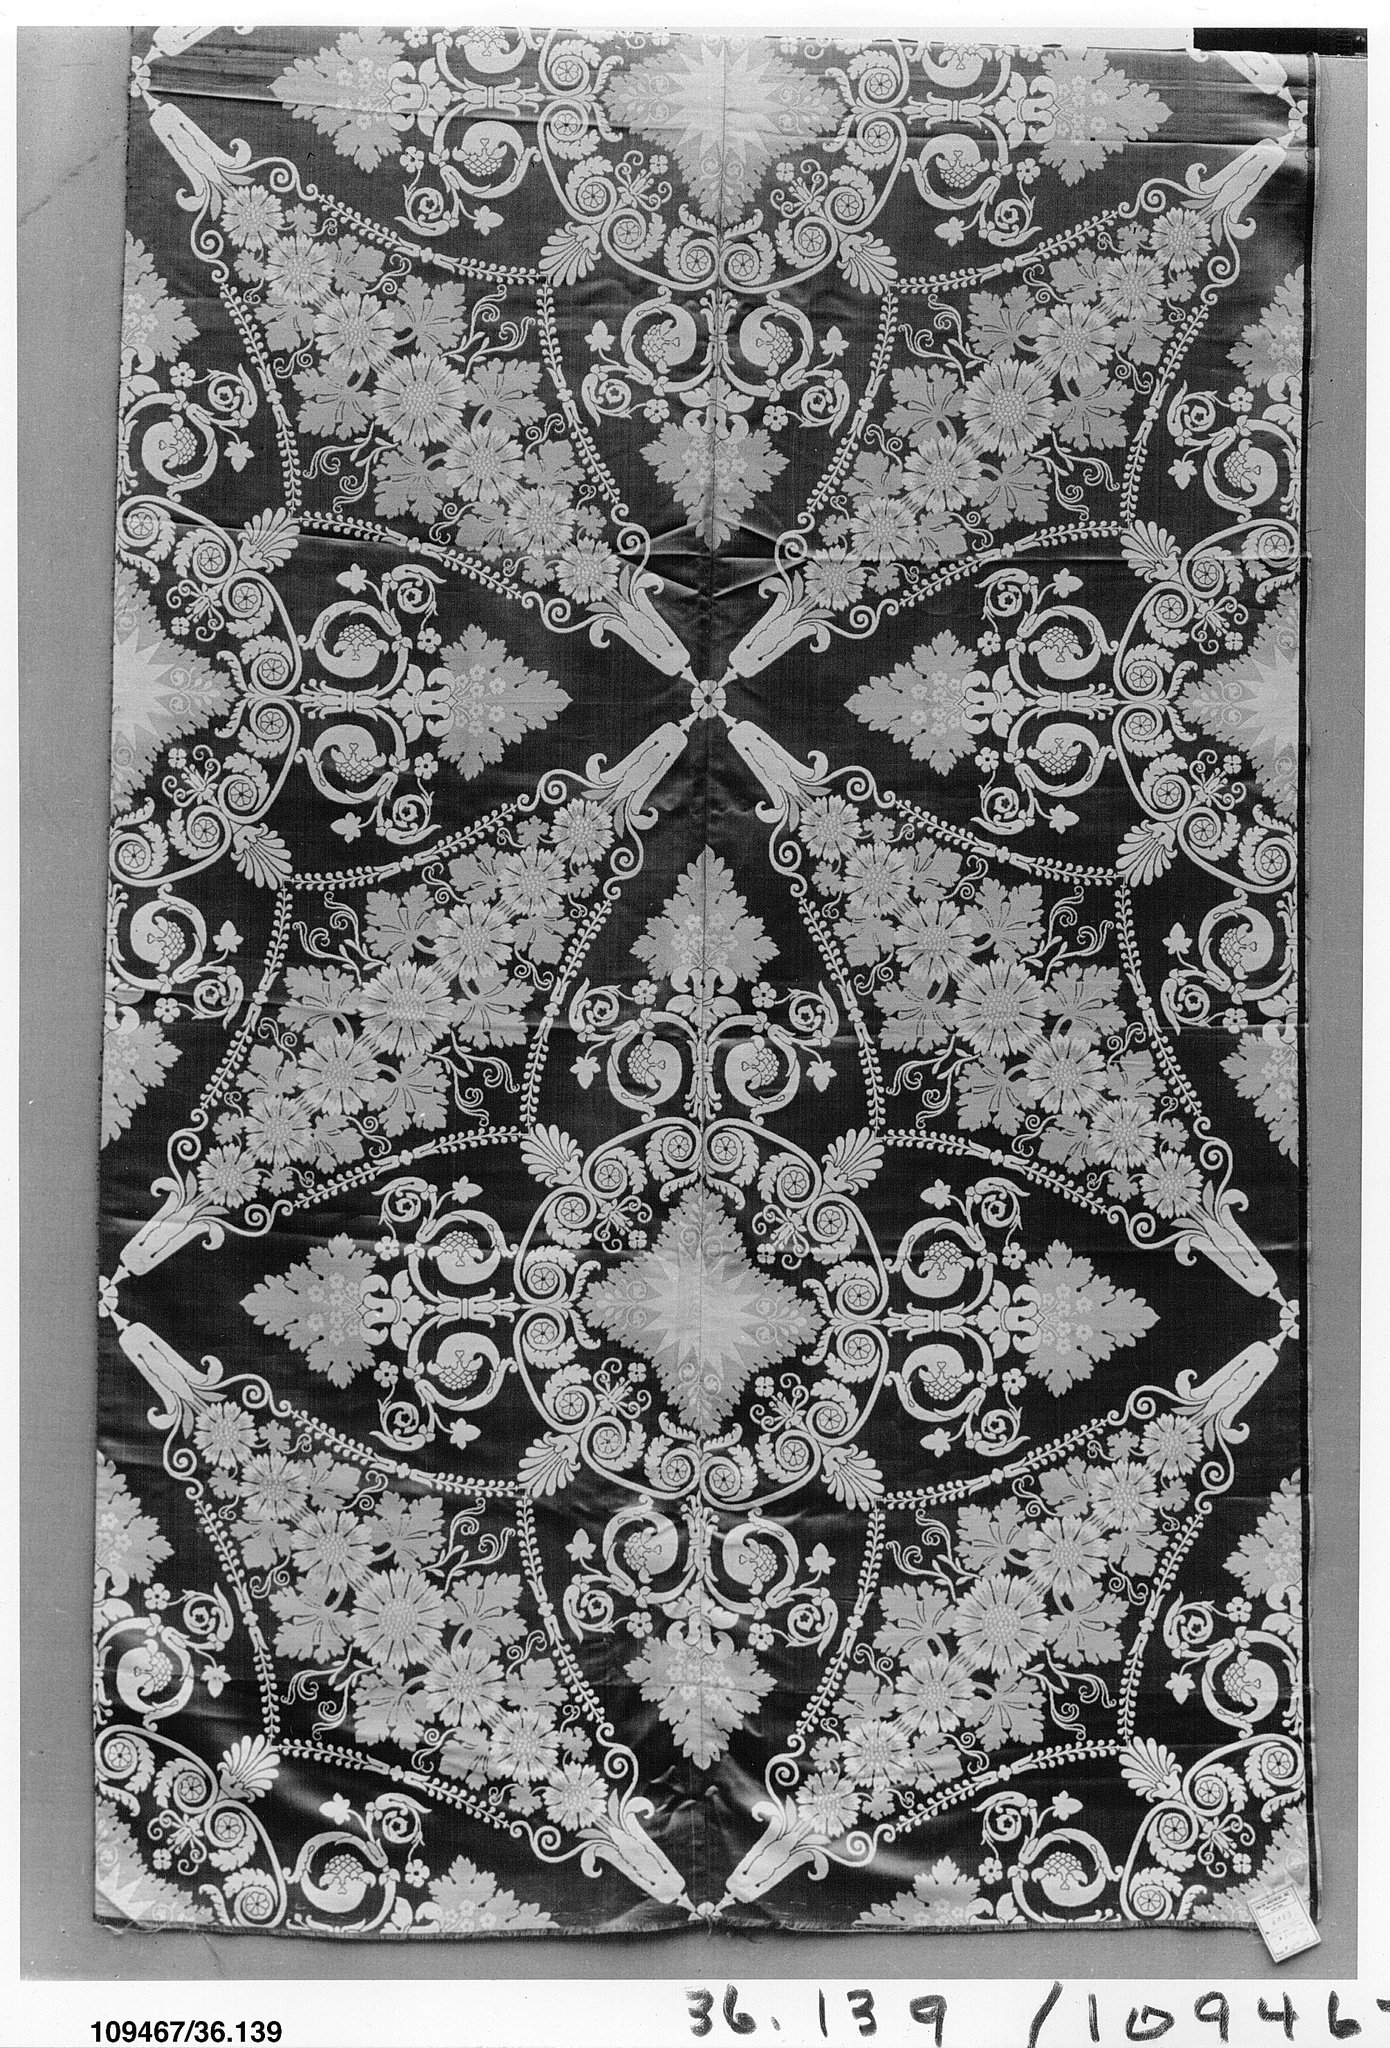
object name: length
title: Length of furnishing fabric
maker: camille pernon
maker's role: workshop director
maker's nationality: french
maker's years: 1753-1808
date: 1807-1808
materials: silk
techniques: weave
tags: flowers